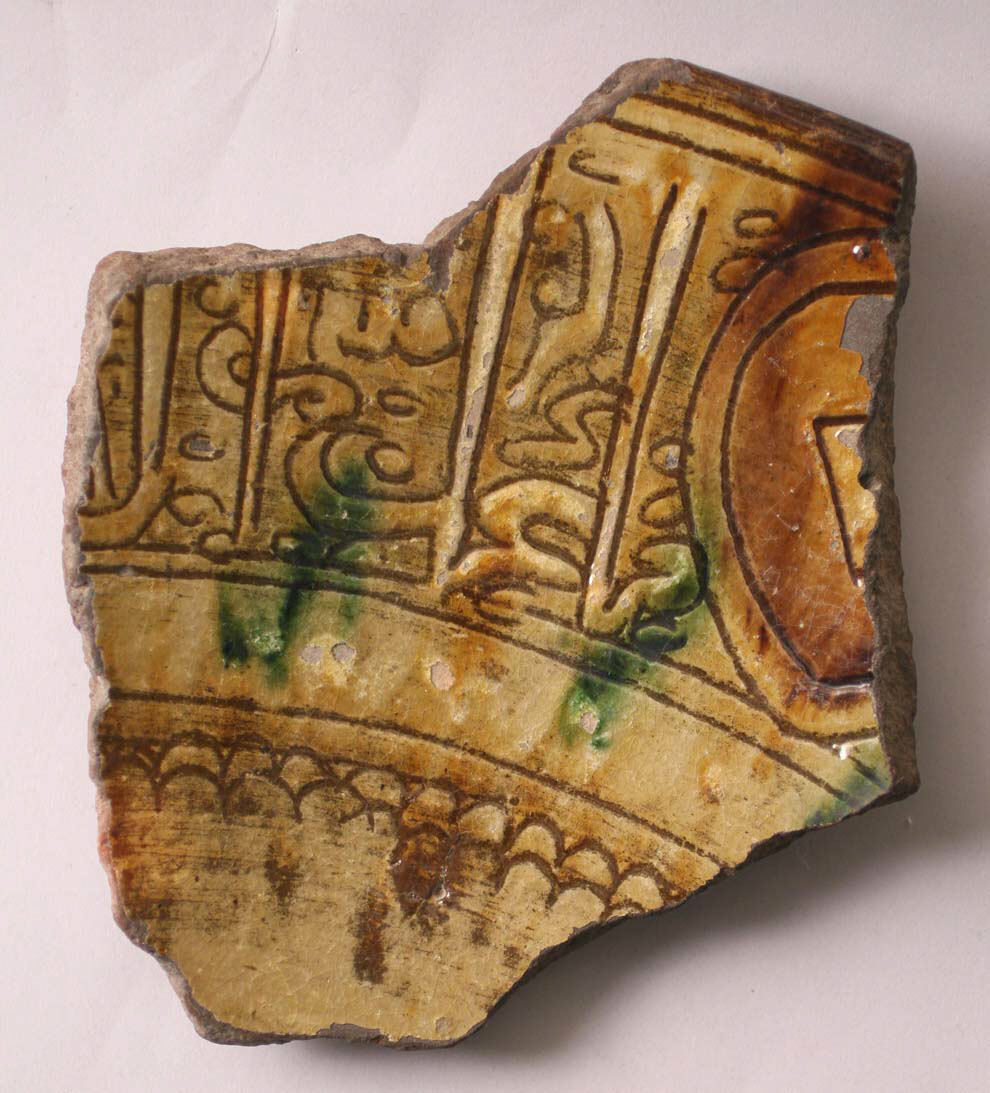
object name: fragment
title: Ceramic Fragment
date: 1301-1500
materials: earthenware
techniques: glazing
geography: egypt